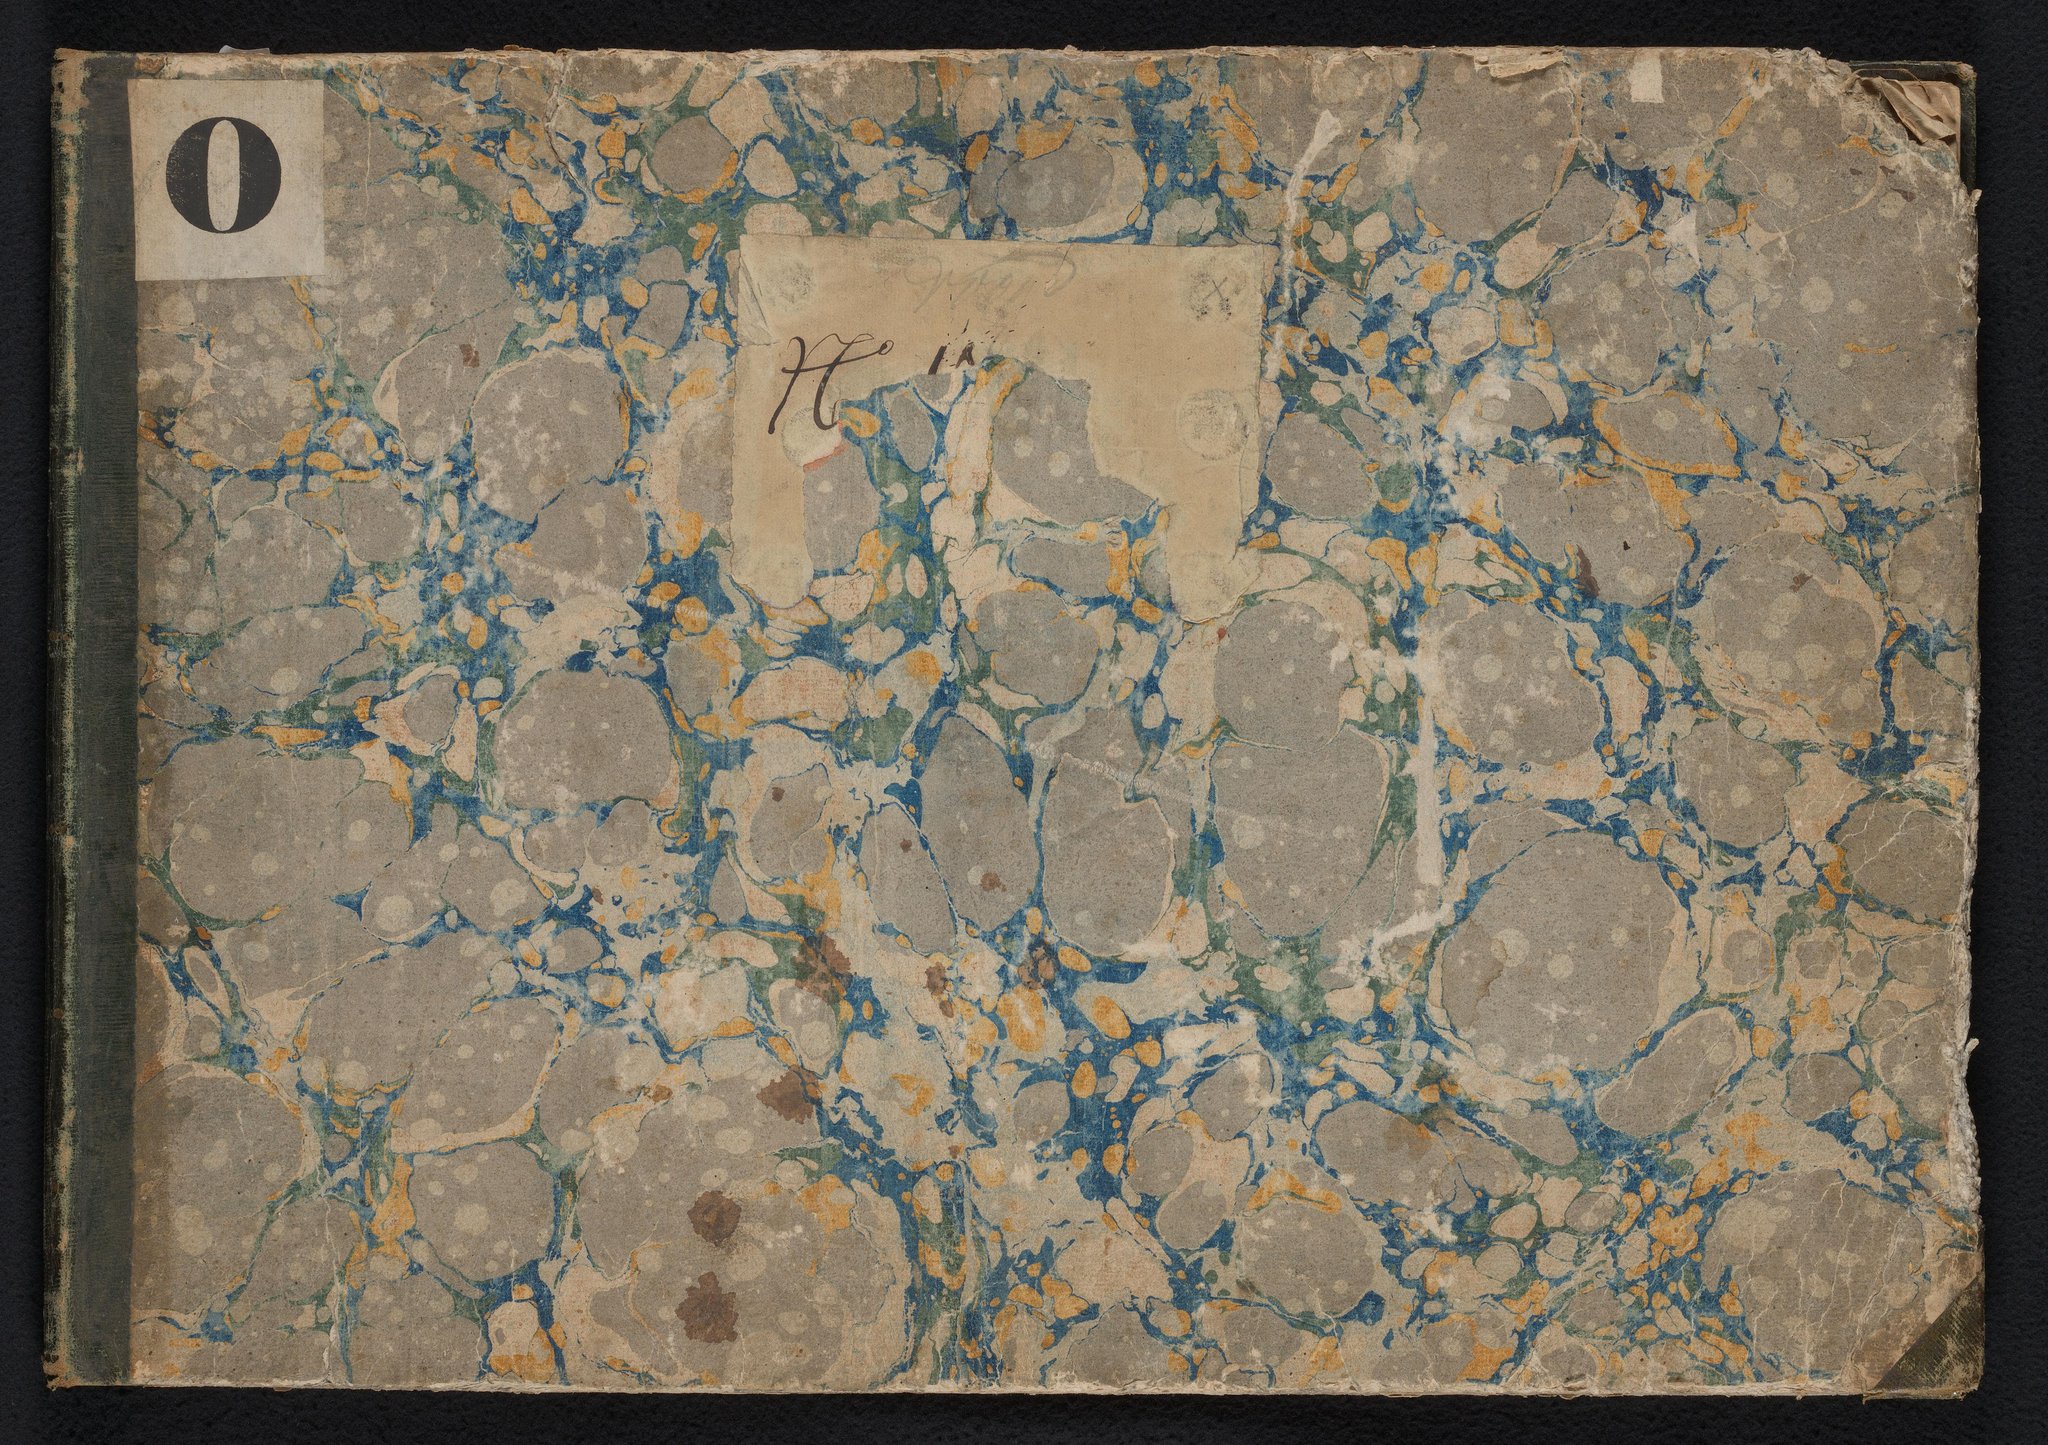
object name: tekeningenalbum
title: Album met schetsen van gezichten in Rome en omgeving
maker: hendrik voogd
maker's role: draughtsman, painter, print maker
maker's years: 1768-1839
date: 1788-1839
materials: gold leaf, leather, paper, pencil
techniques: bookbinding, printing, marbling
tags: city-view, and landscape with man-made constructions, landscapes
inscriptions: inscription: ‘N.50 Studi fatti [...]vero dal Cav. H. Voogd.’, collector's mark: Lugt 2228, inscription: ‘N.1 Studie appreso il vero.’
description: Album met 51 tekeningen op 50 albumbladen met gezichten in Rome, Roccantica, Belmonte, Tivoli, Subiaco en Scandriglia. Met achterin een fotoreproductie van de tekening op albumblad 47.